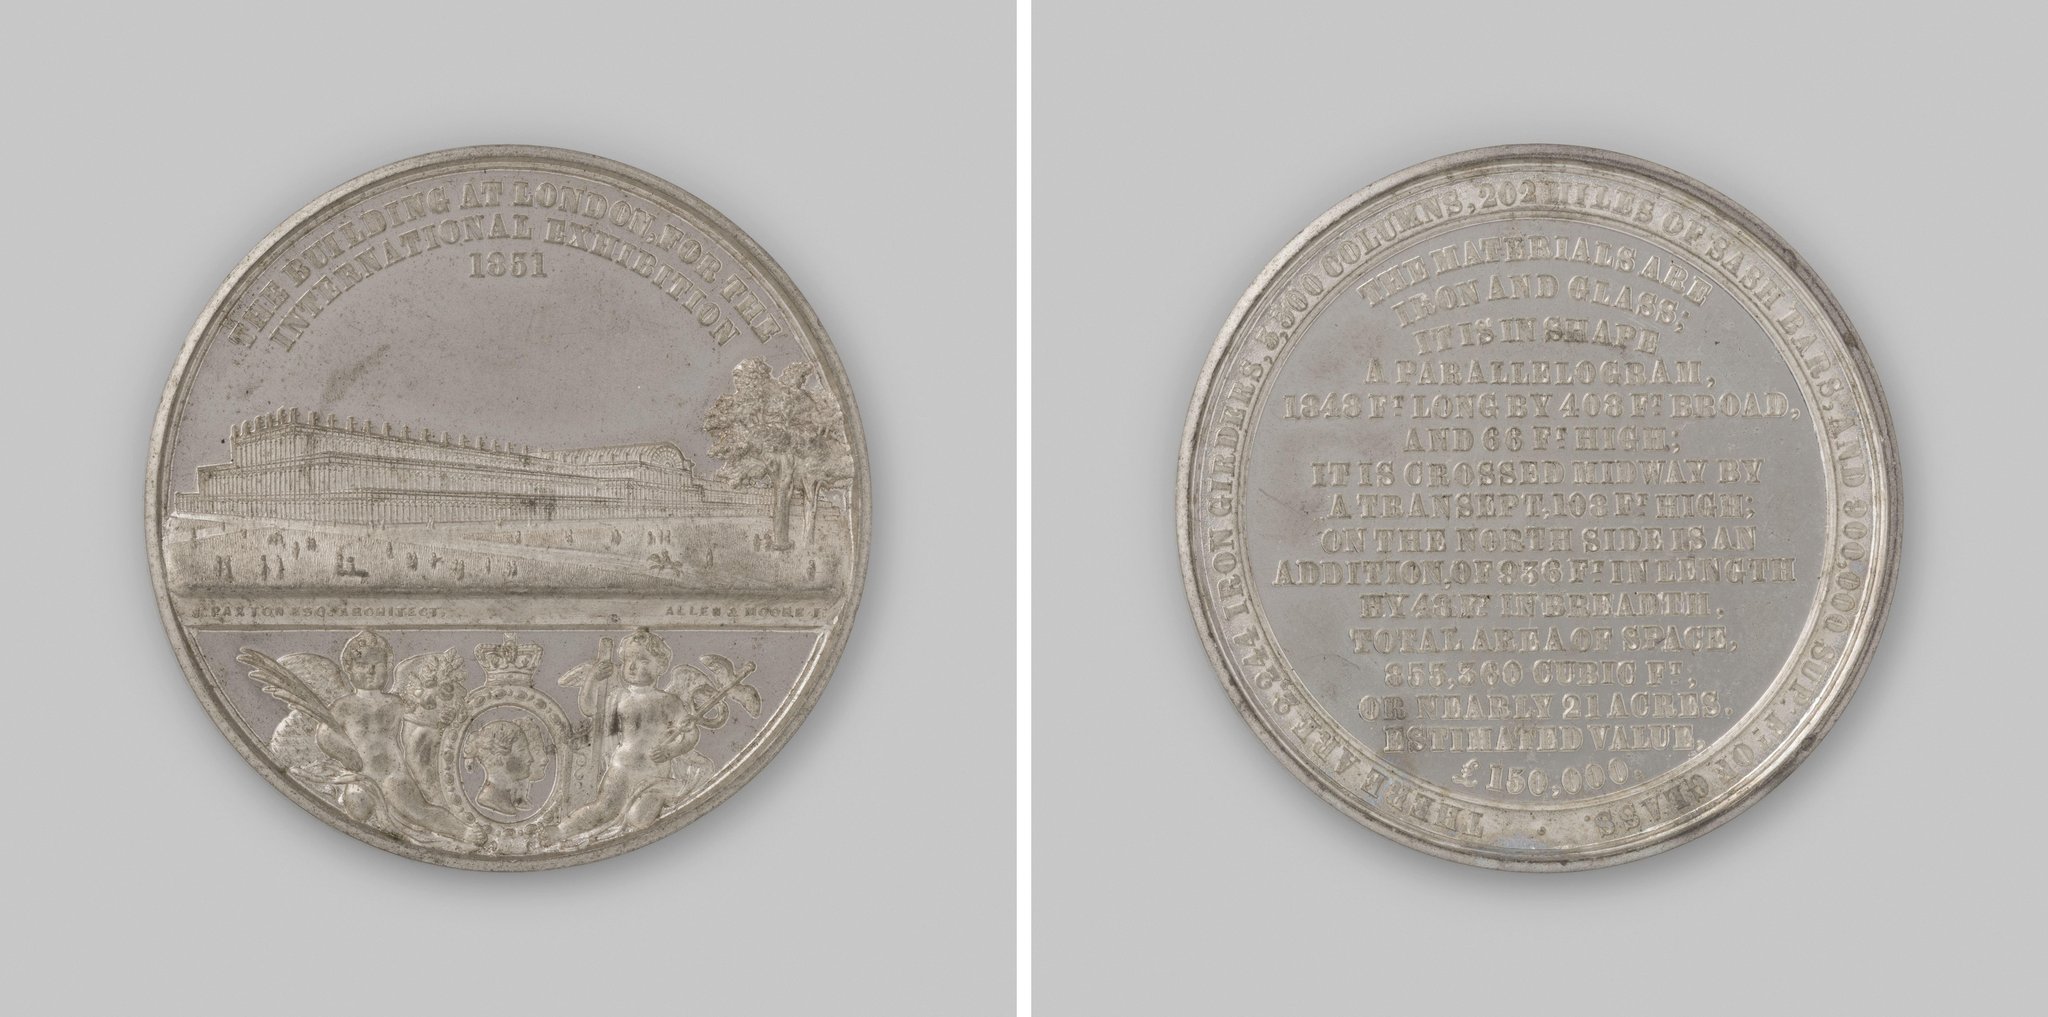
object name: history medal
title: Bouw van het Crystal Palace voor de internationale tentoonstelling van industrie te Londen, ter ere van Victoria, koningin van Groot-Britannie en Albert, prins van Saksen-Coburg-Gotha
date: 1851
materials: alloy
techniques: striking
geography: birmingham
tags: victoria (koningin van het verenigd koninkrijk en keizerin van india), albert (prins van saksen-coburg en gotha)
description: Penning. Voorzijde: paleis binnen omschrift; afsnede: borststuk vrouw en man in gekroonde portretmedaillon tussen twee engeltjes, waarvan linker palmtak en gevulde hoorn van overvloed draagt en rechter scheepsroer en Mercuriusstaf. Keerzijde: opschrift binnen omschrift.